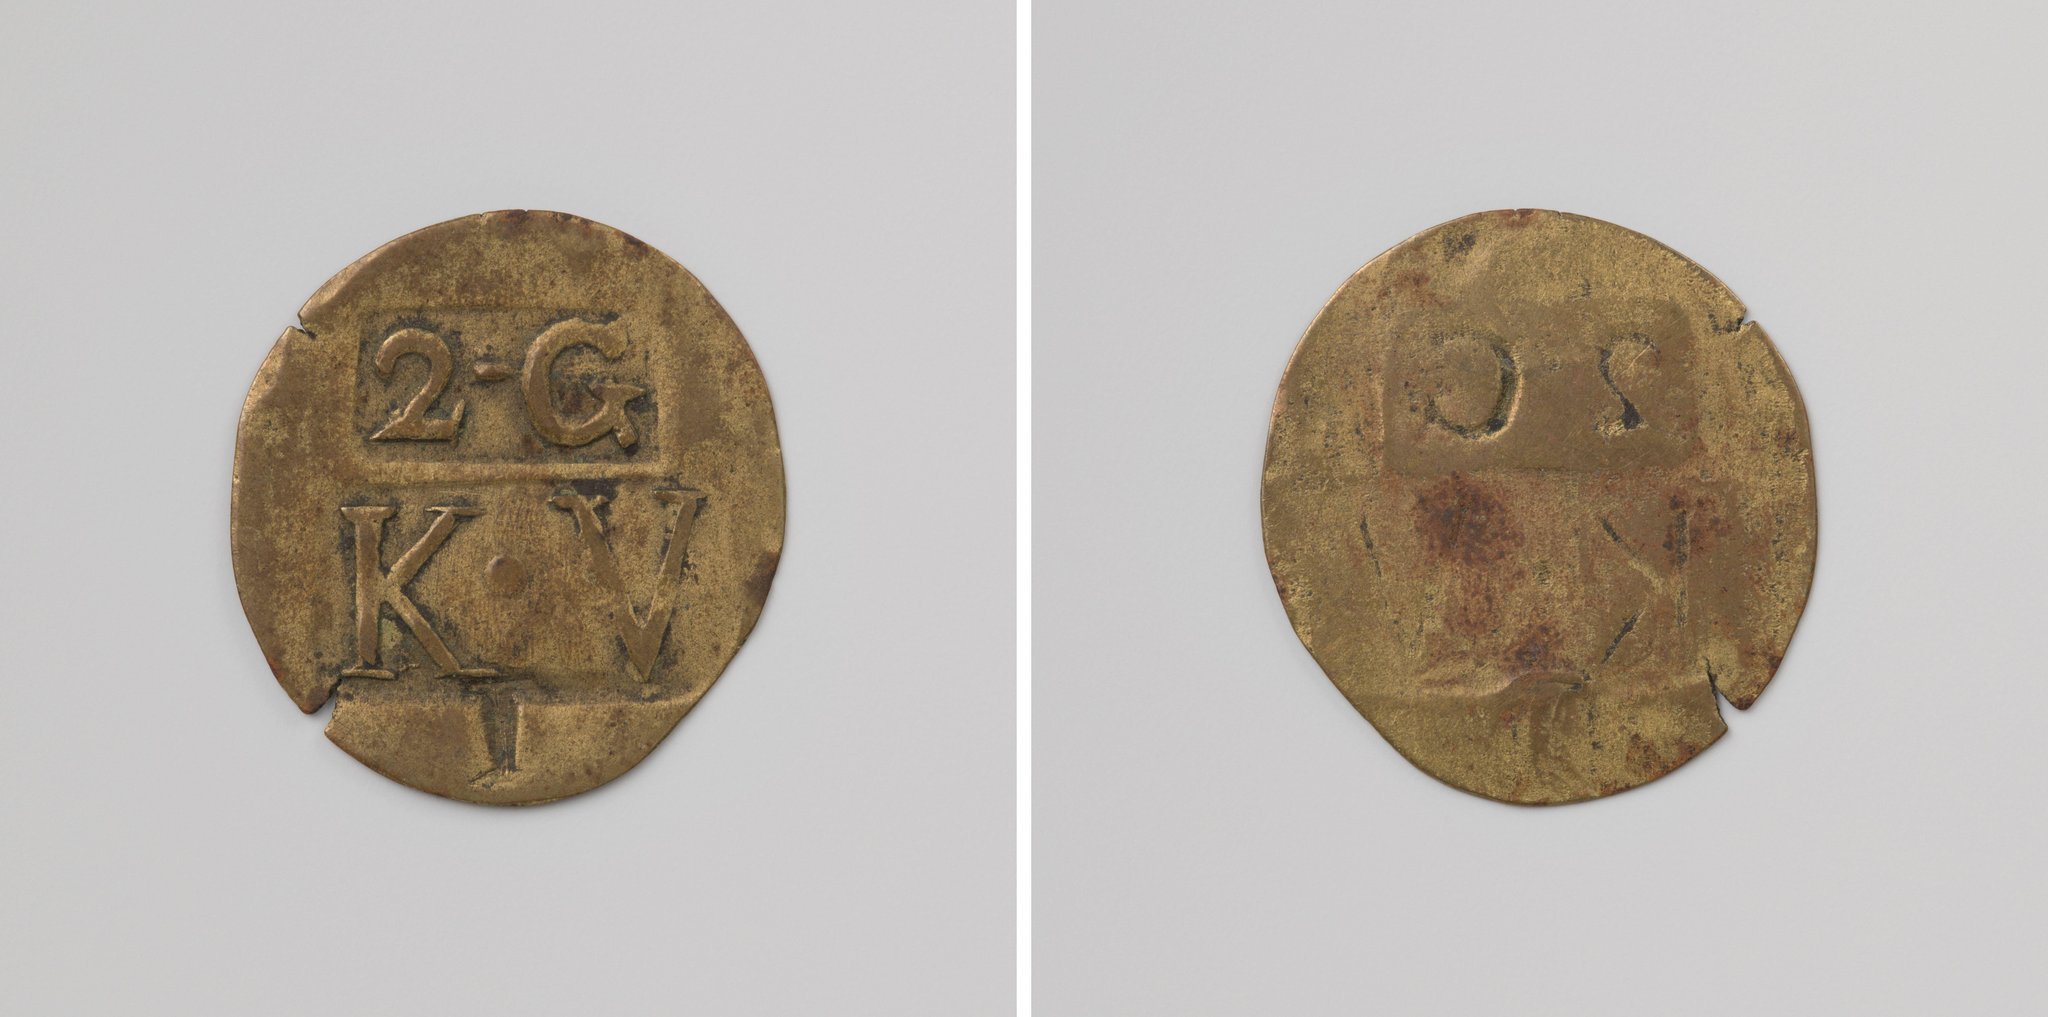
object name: huismunt prison money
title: Tweede gesticht van de kolonie Veenhuizen, huismunt geslagen op last van de Maatschappij van Weldadigheid ter waarde van 1 cent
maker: Anonymous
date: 1818-1859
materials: brass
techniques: striking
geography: netherlands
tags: maatschappij van weldadigheid, veenhuizen